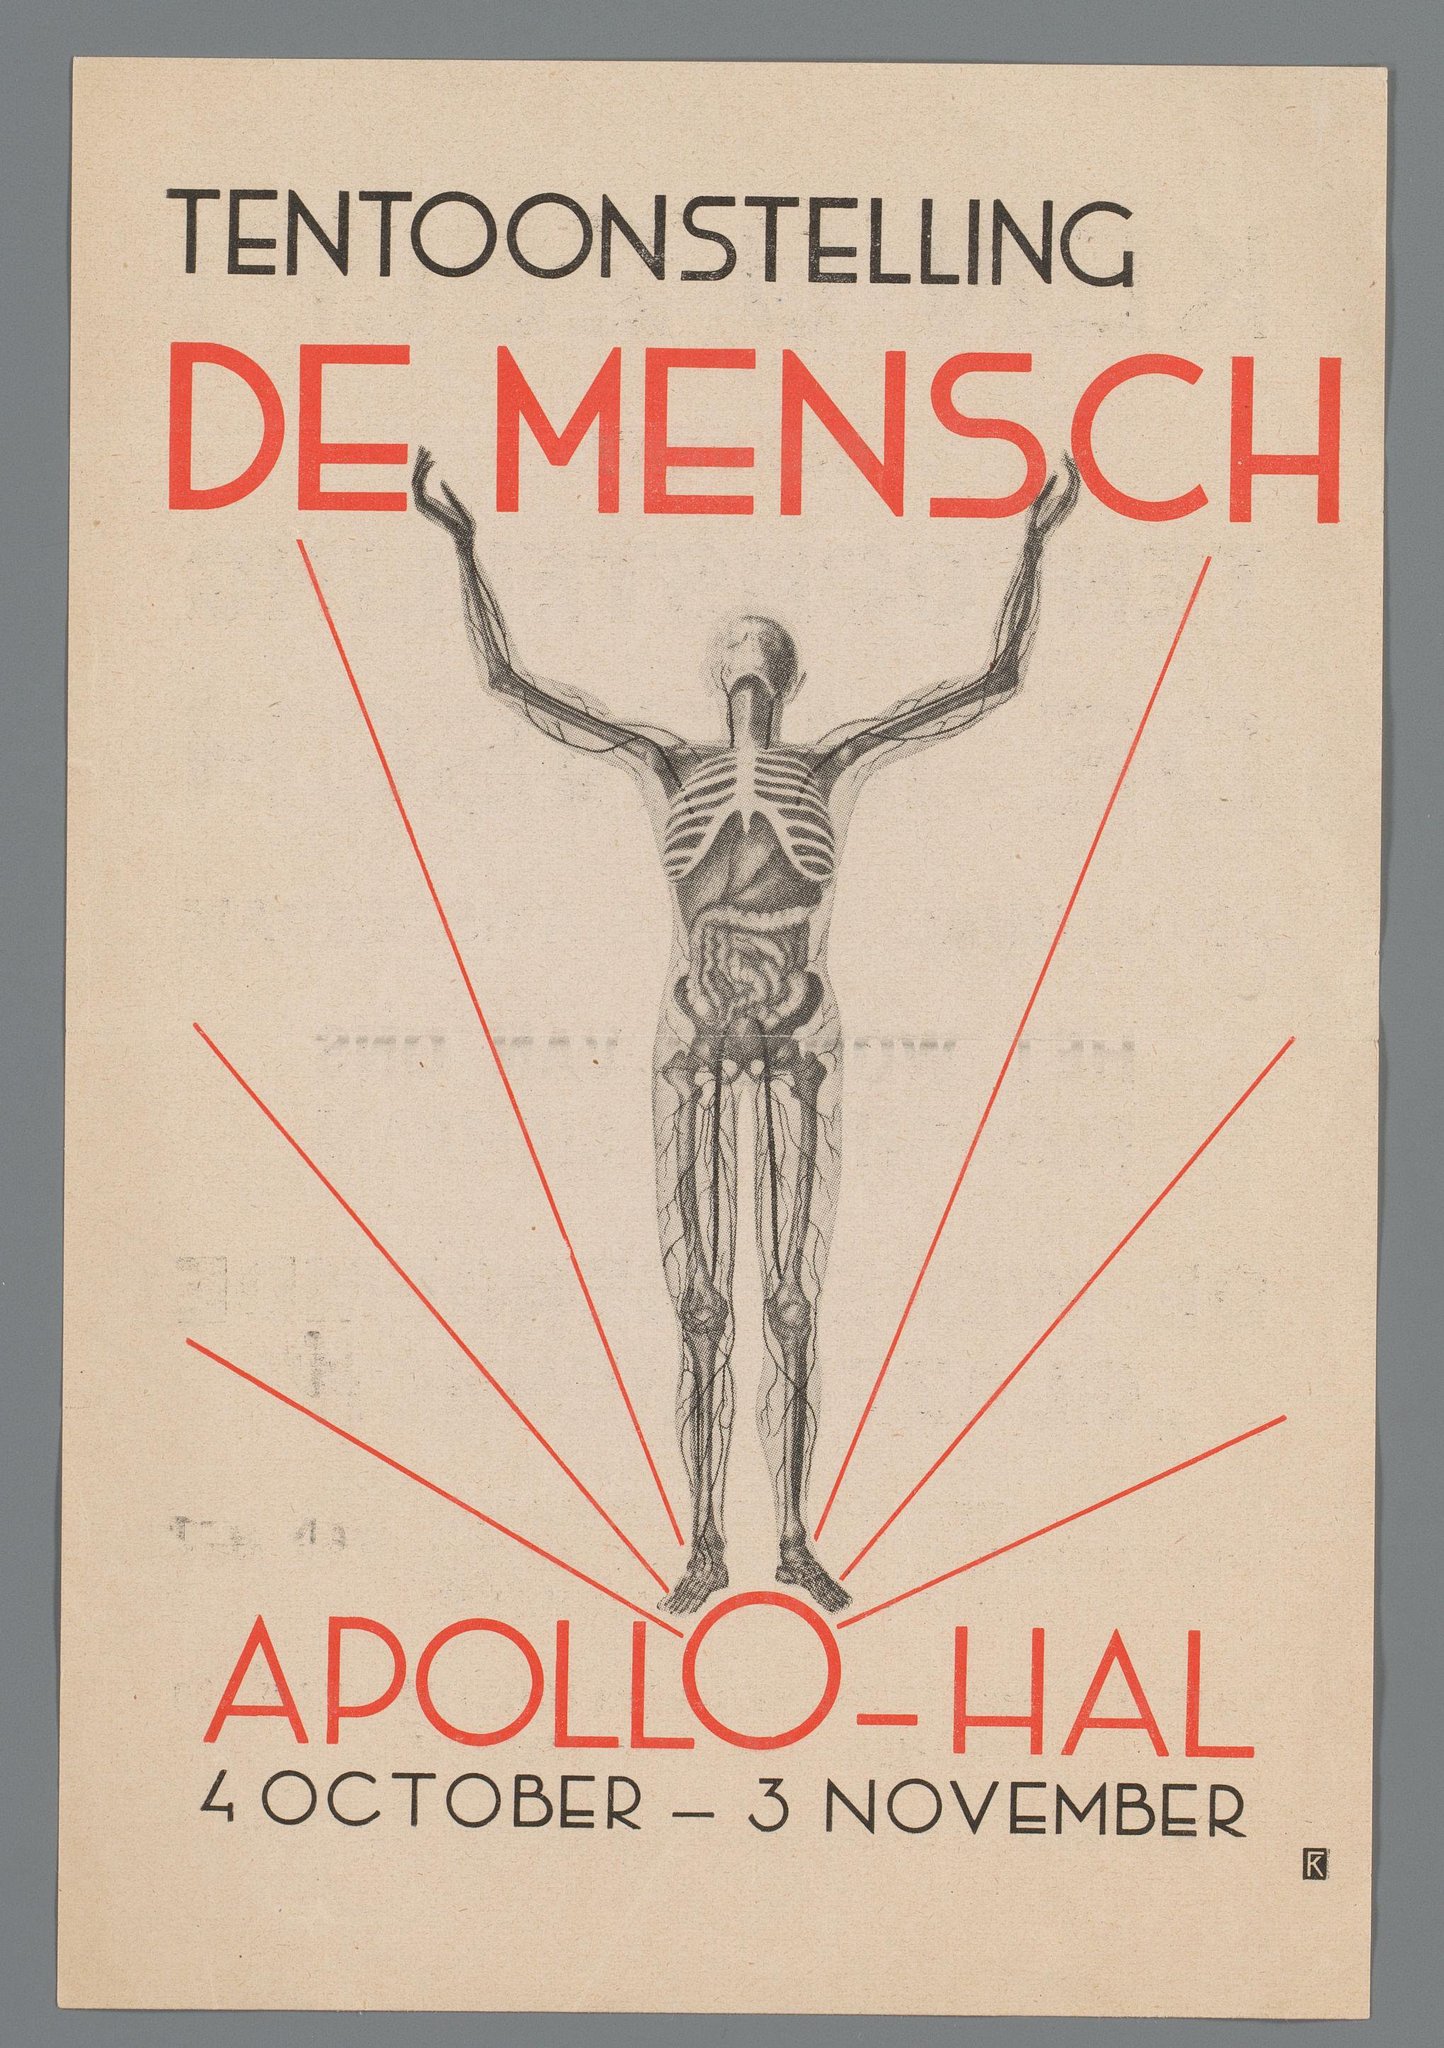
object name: invitation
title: Uitnodiging voor de tentoonstelling 'De Mensch' in de Apollohal in Amsterdam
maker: Anonymous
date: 1935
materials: paper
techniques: autotype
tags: arm raised upward - aa - both arms or hands, physiology and anatomy, collection, exhibition, show, amsterdam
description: De 'Glazen mensch' zoals geadverteerd op de achterzijde van het blad, een doorzichtig model van een man met opgeheven armen zodat de organen en botten goed te zien zijn. Op de achterzijde een beschrijving van de tentoonstelling, die van 4 oktober tot en met 3 november 1935 werd gehouden in de Apollohal in Amsterdam.